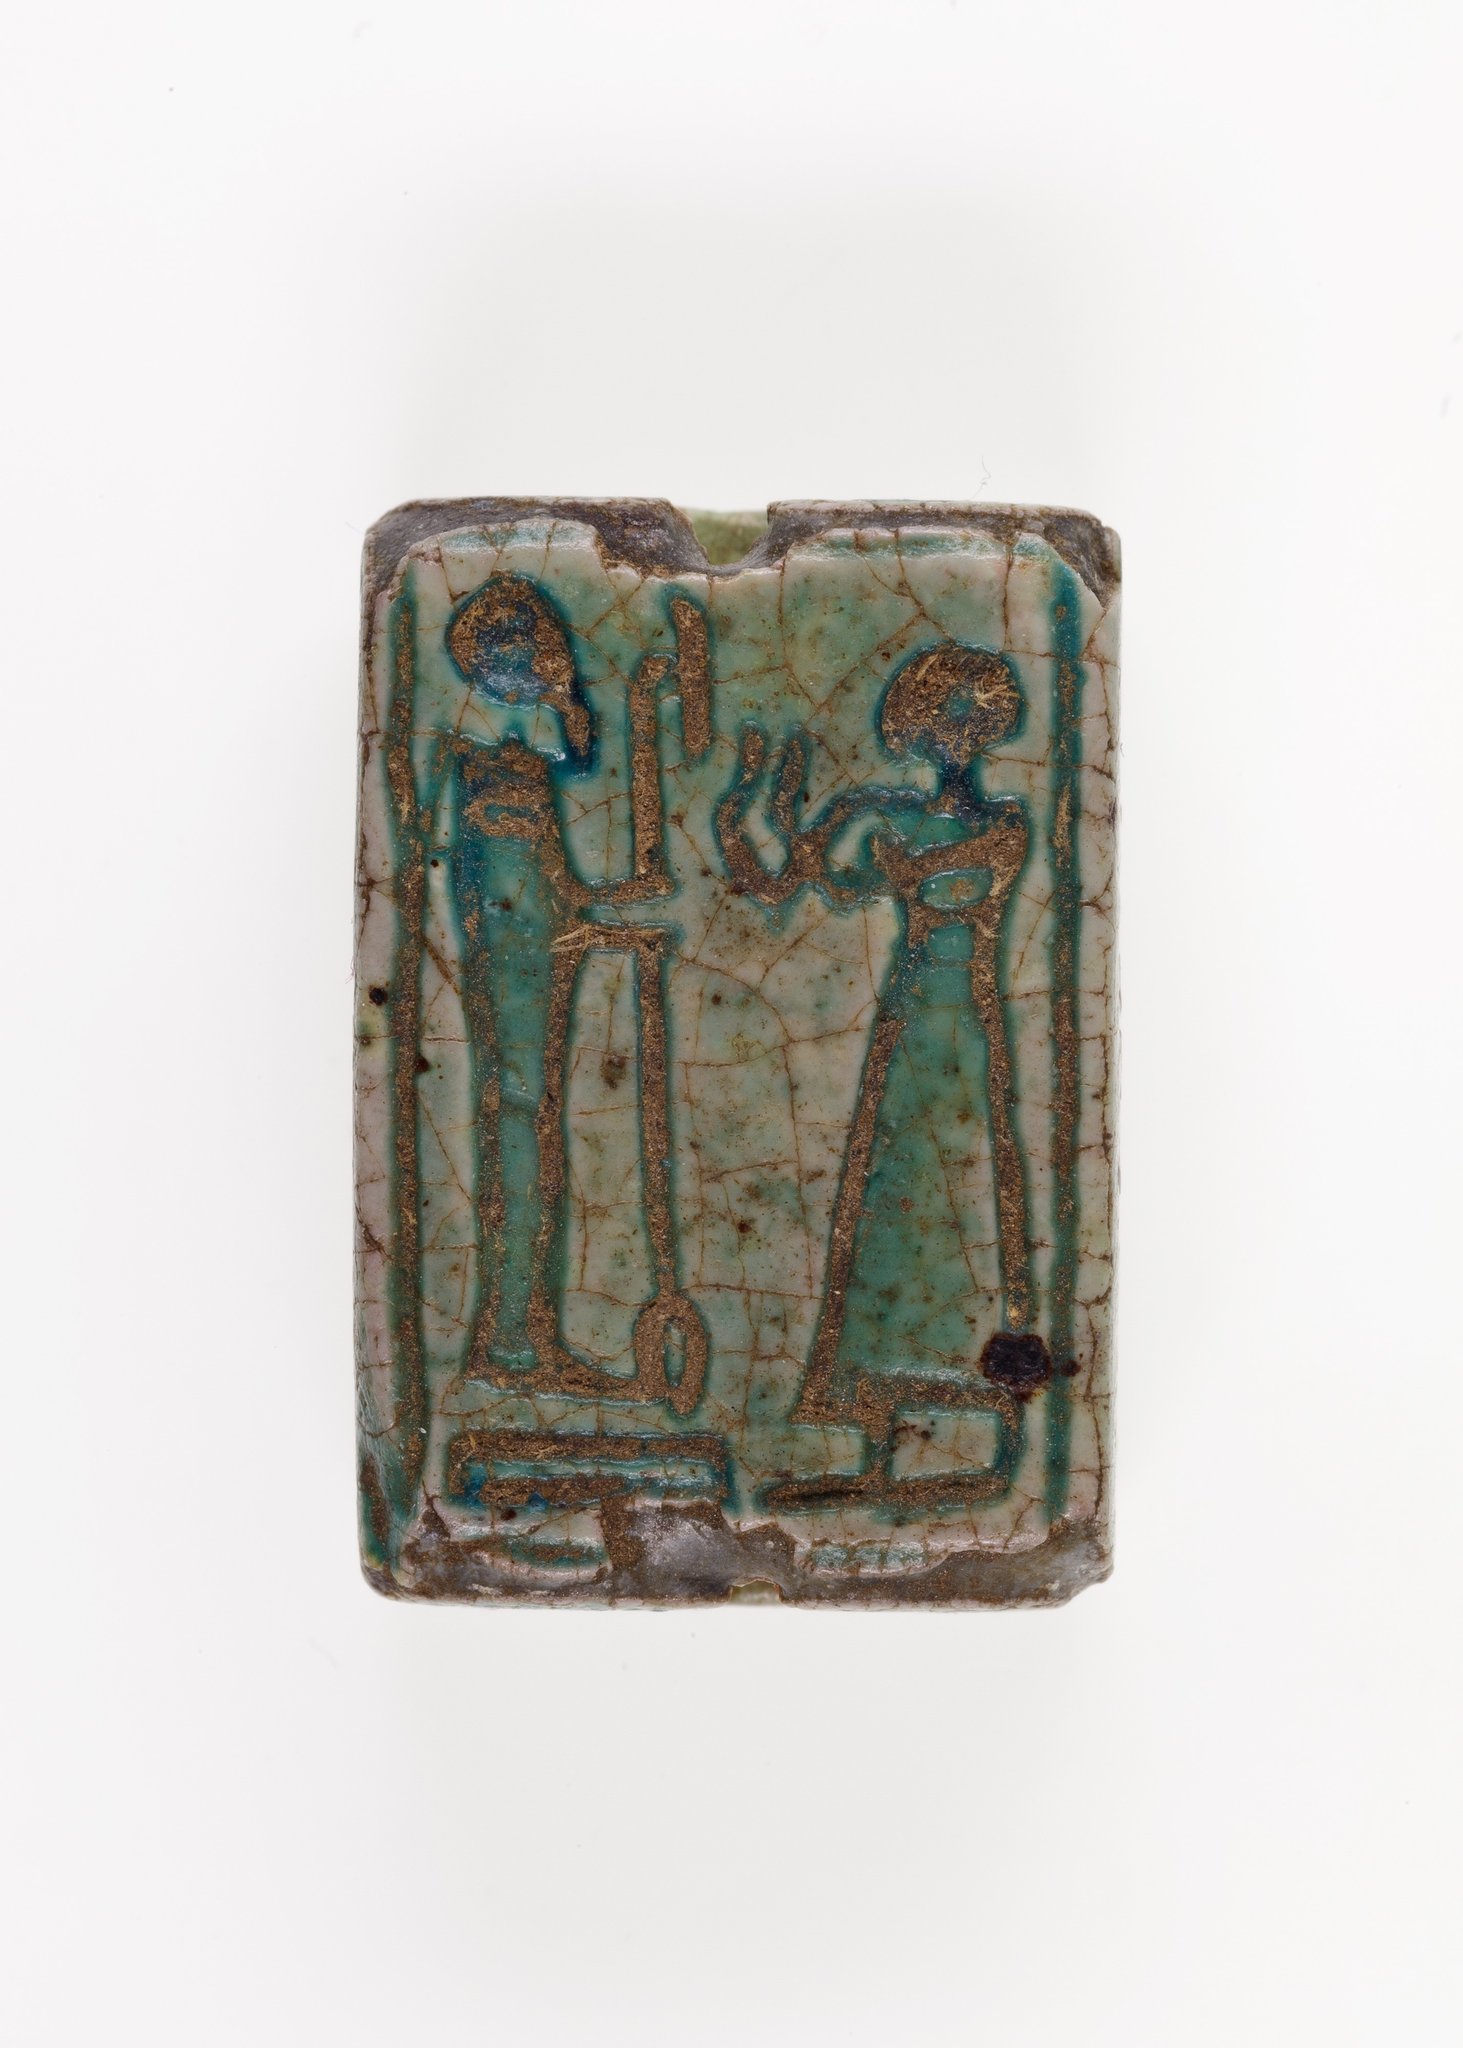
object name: amulet, stamp, bead, plaque, paser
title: Amuletic plaque of Paser, the Vizier of Seti I and Ramesses II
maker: paser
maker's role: patron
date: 1294-1213 BCE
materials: stone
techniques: glazing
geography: egypt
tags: hieroglyphs